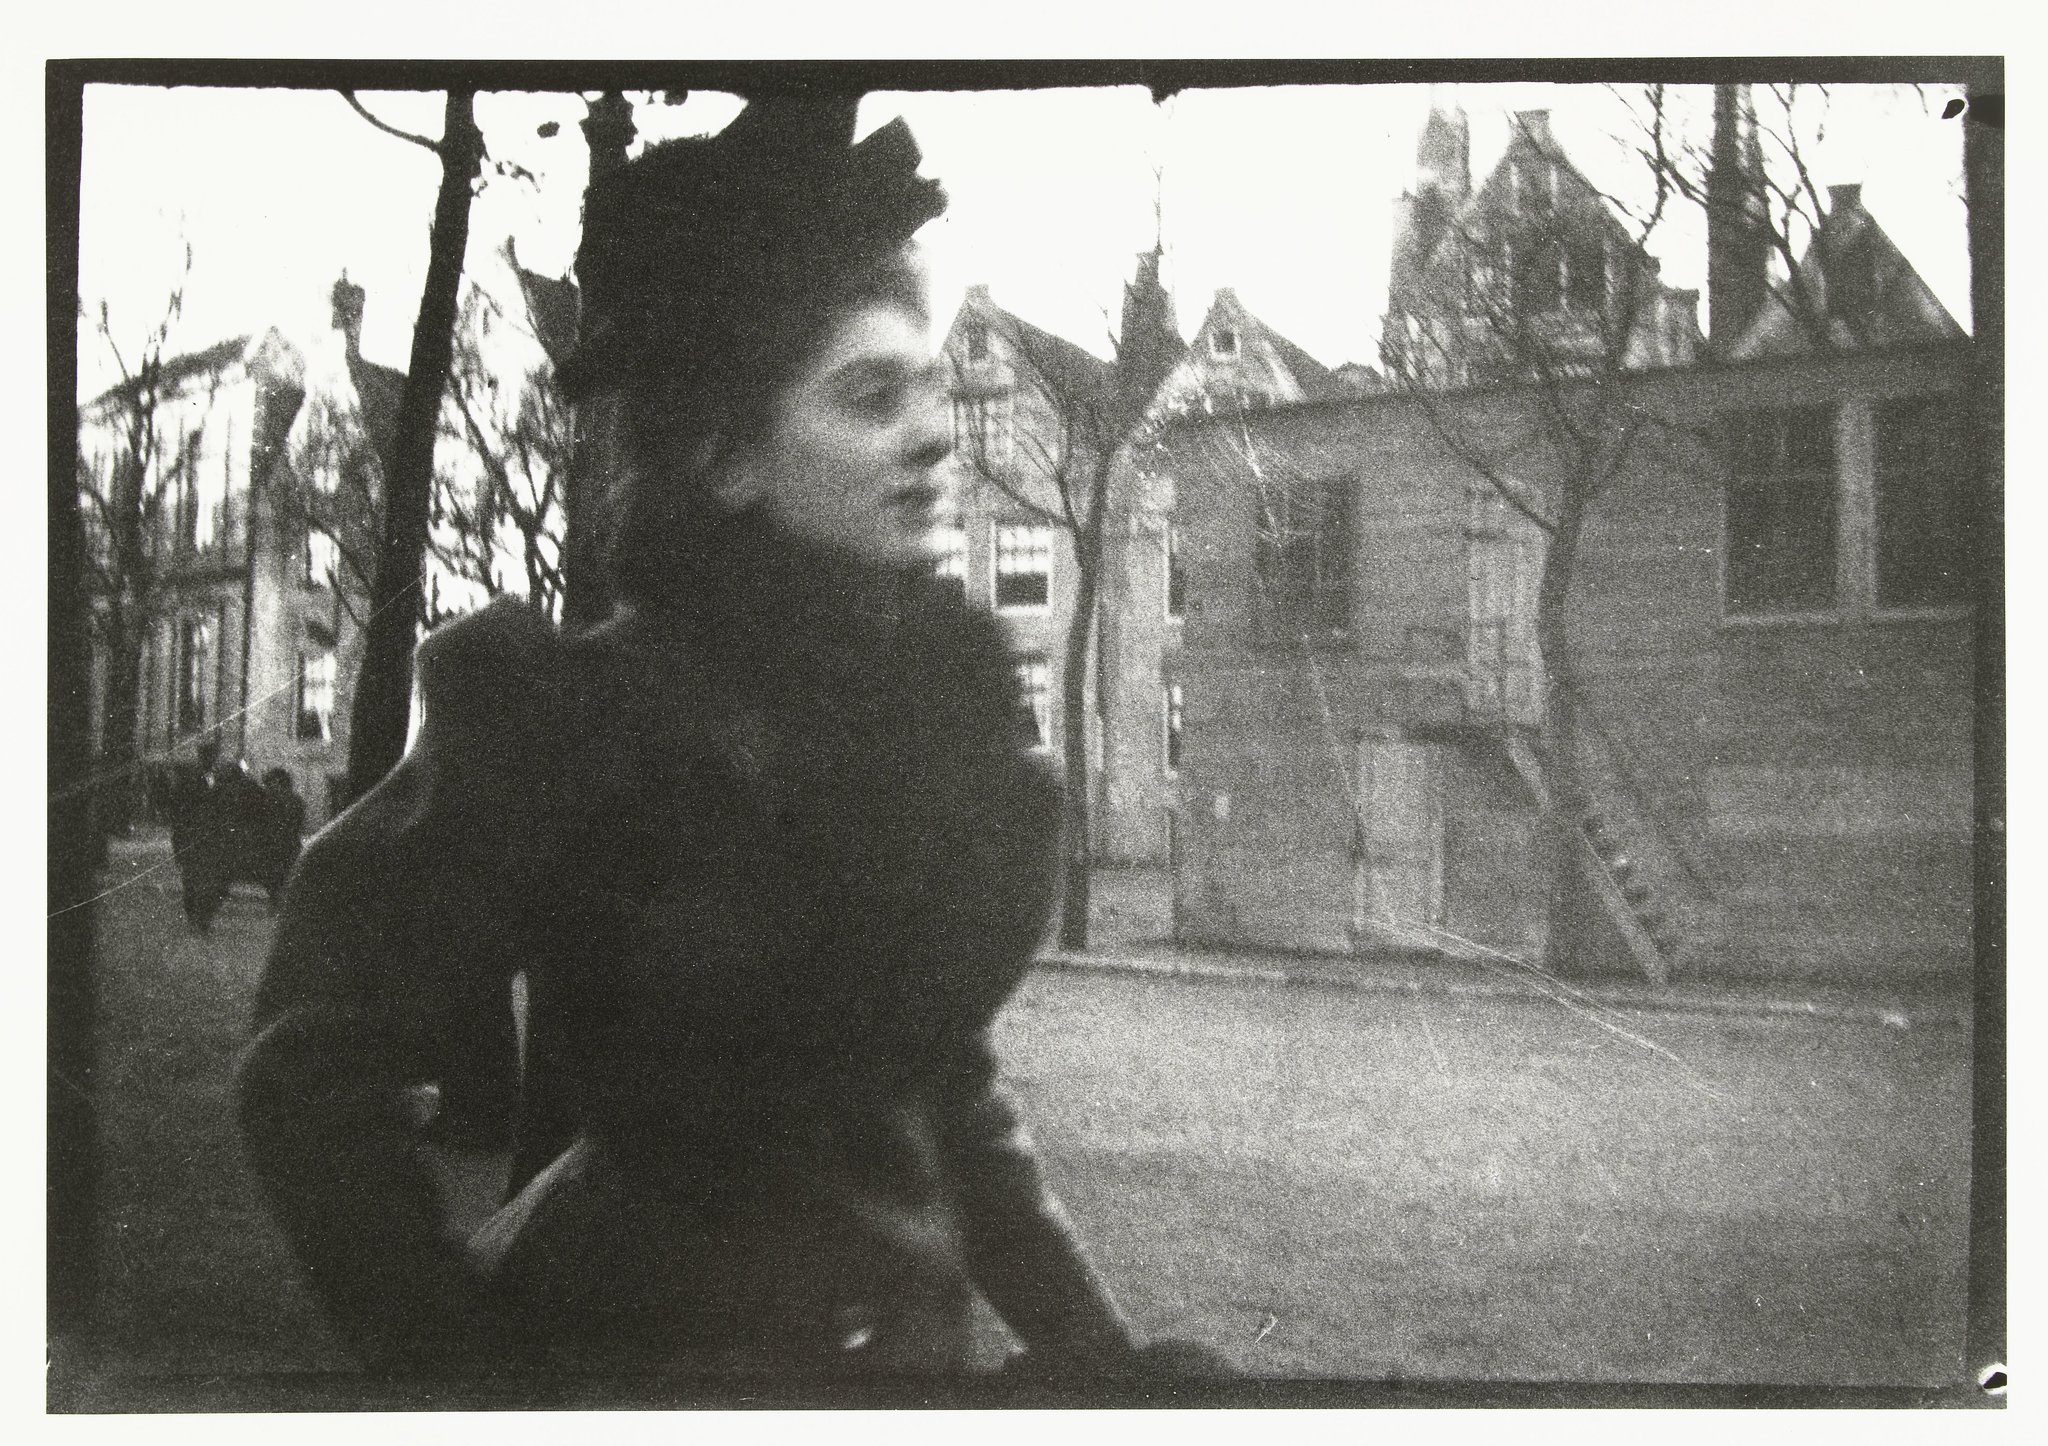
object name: photograph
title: Portret van een vrouw op het Spui in Amsterdam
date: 1890-1910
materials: paper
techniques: gelatin silver print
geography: amsterdam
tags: spui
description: Moderne afdruk van negatief BR 727 (collectie RKD).